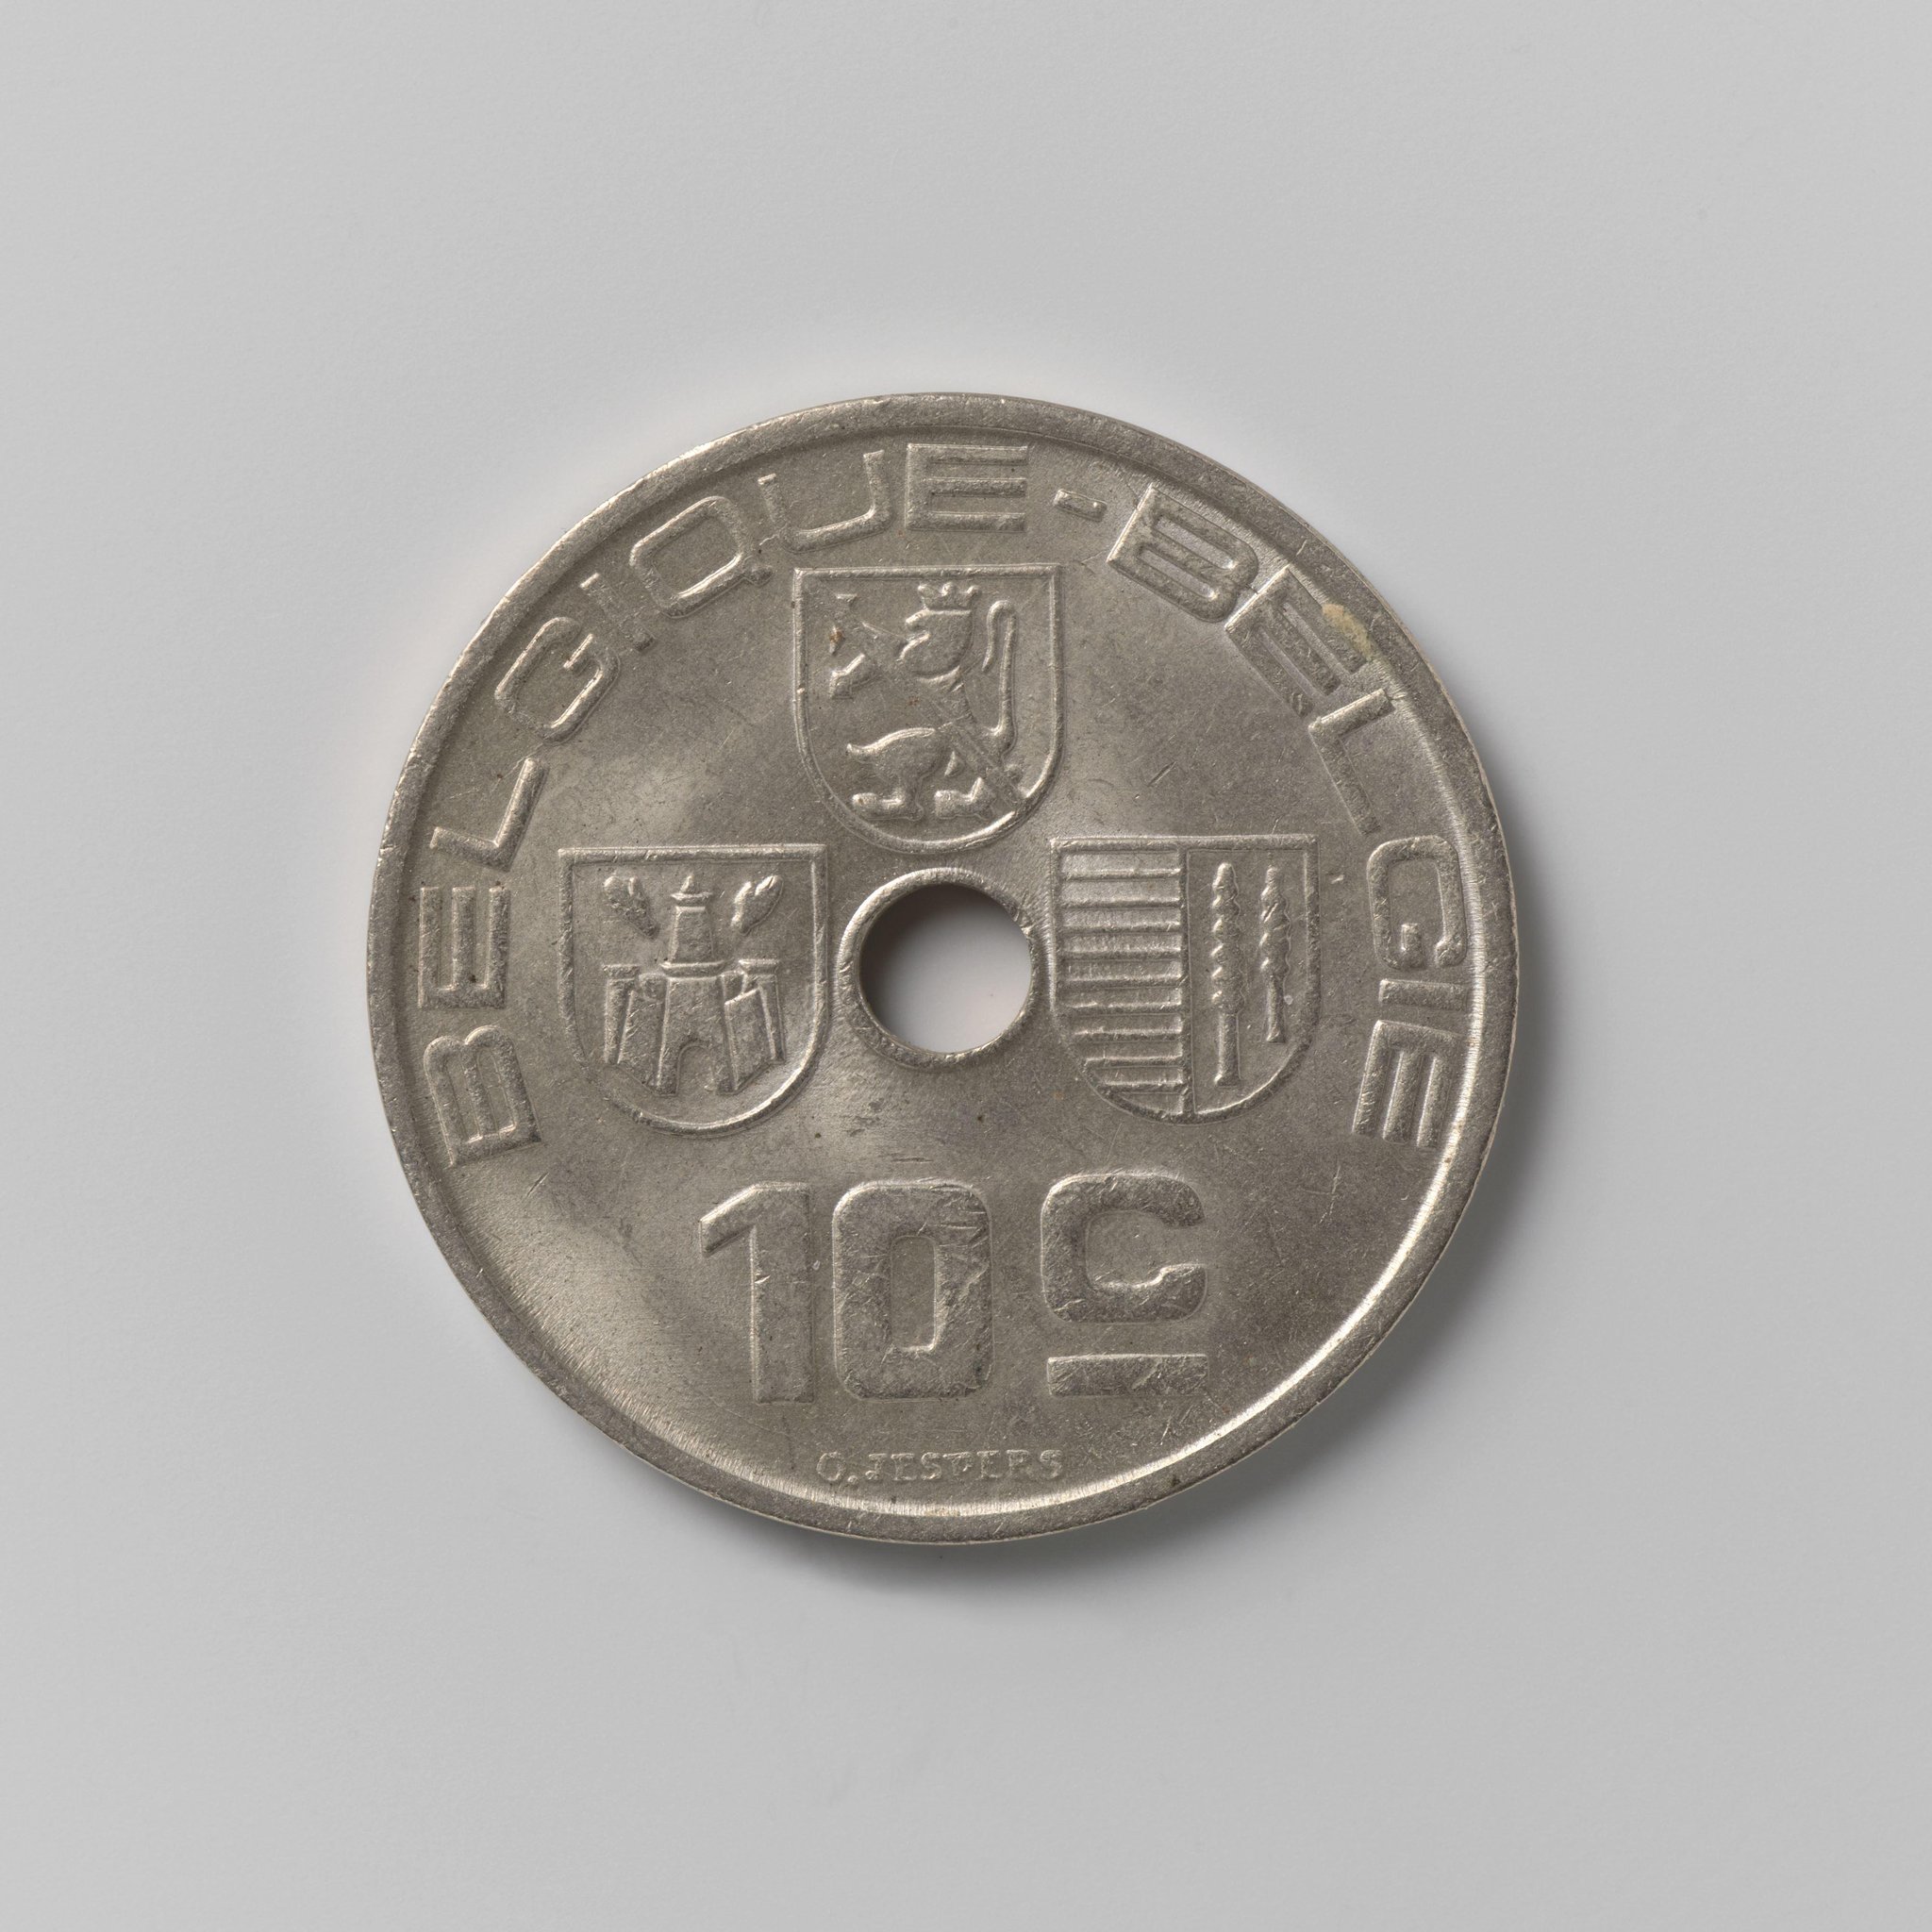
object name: coin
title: België, Albert I, 10 centimes, 1939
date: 1939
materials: nickel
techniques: striking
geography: brussels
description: Nikkelen munt. Voorzijde: gekroond monogram van twee letters L, waartussen III. Jaaartal onderaan. Keerzijde: drie wapenschilden, waaronder waarde-aanduiding. Centrale doorboring. Gladde rand.